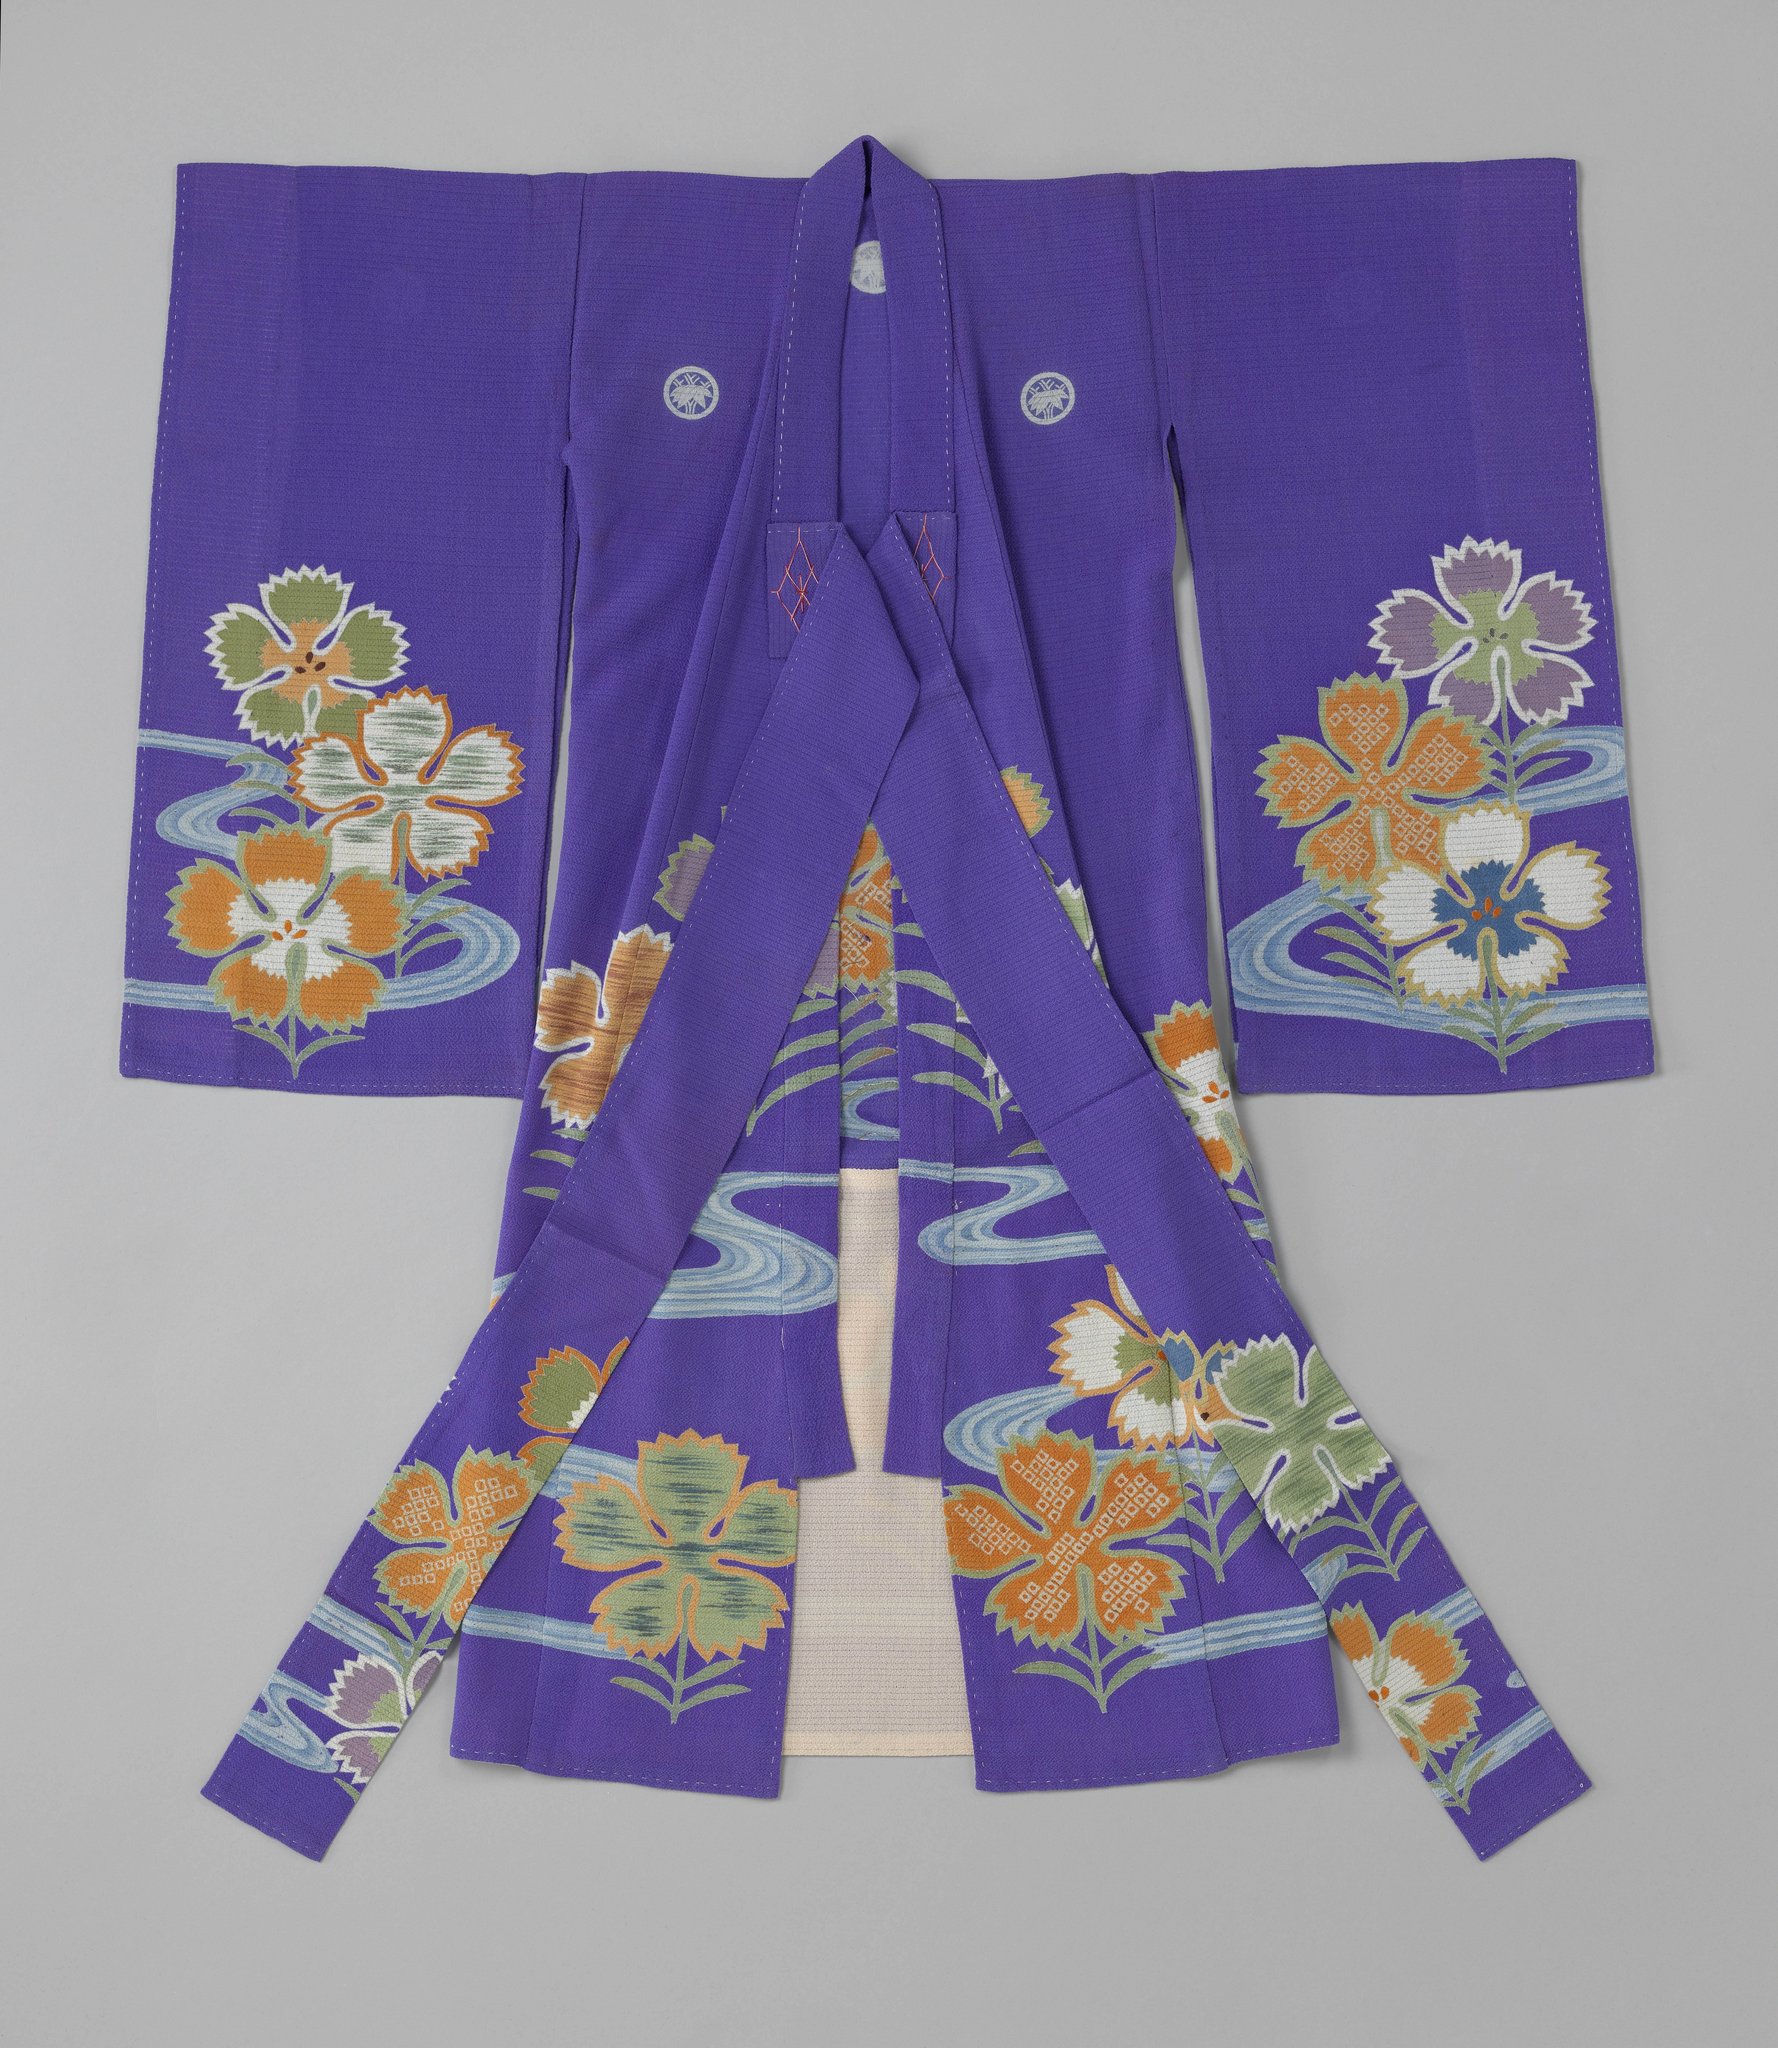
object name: kimono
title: Meisjes miyamairi kimono met anjelieren en water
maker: Anonymous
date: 1920-1940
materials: silk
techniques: embroidered, painting, weave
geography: japan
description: Formele kimono voor een meisje voor het eerste bezoek aan een Shinto schrijn (miyamairi kimono), met een versiering van wilde anjers in rood, groen, blauw, wit en oranje, waartussen gestileerde golven lopen, op een paarse achtergrond. Paarse gaasgeweven crepe zijde (ro chirimen) met een geschilderde yuzen decoratie en geborduurde detaillering. Voering van witte gaasgeweven crepe zijde (ro chirimen). Vijf familiewapens (mon) van bamboe.